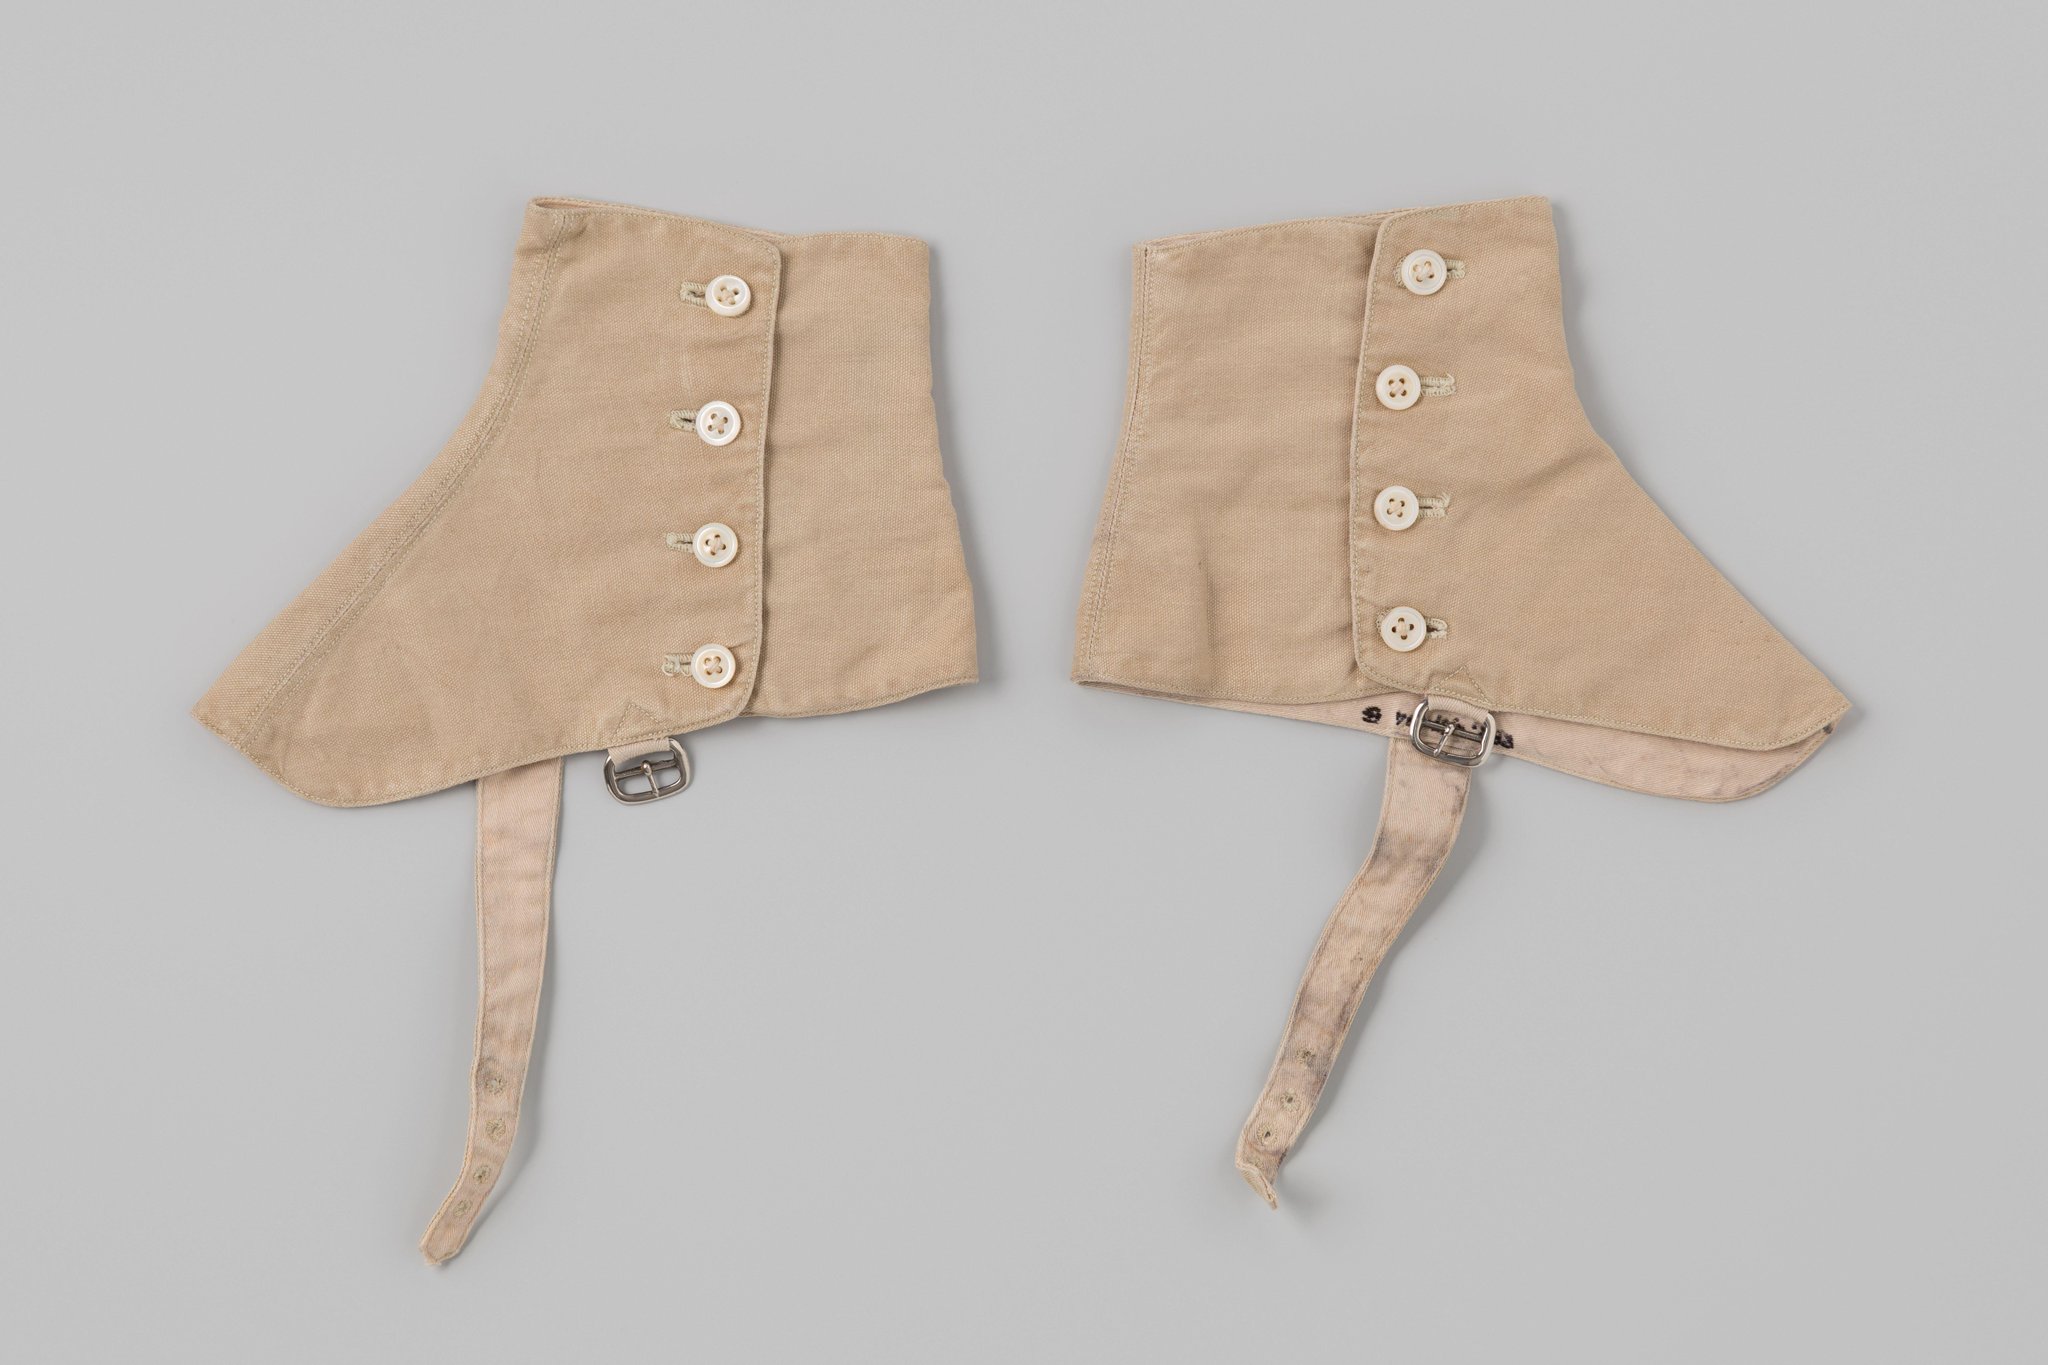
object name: clothing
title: Slobkous van zandkleurig linnenkatoen waarop vier parelmoerkleurige knopen en een linnen riem met metalen gesp onder de voet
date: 1900-1930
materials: cotton, metal, plastic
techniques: weave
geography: england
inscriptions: label: ‘'The Diamond Gaiter. Reg'd. Made in England'’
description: Slobkous van zandkleurig linnenkatoen waarop vier parelmoerkleurige knopen en een linnen riem met zilverkleurige metalen gesp onder de voet. Gevoerd met katoen. Binnenin een etiket met: 'The Diamond Gaiter. Reg'd. Made in England'.